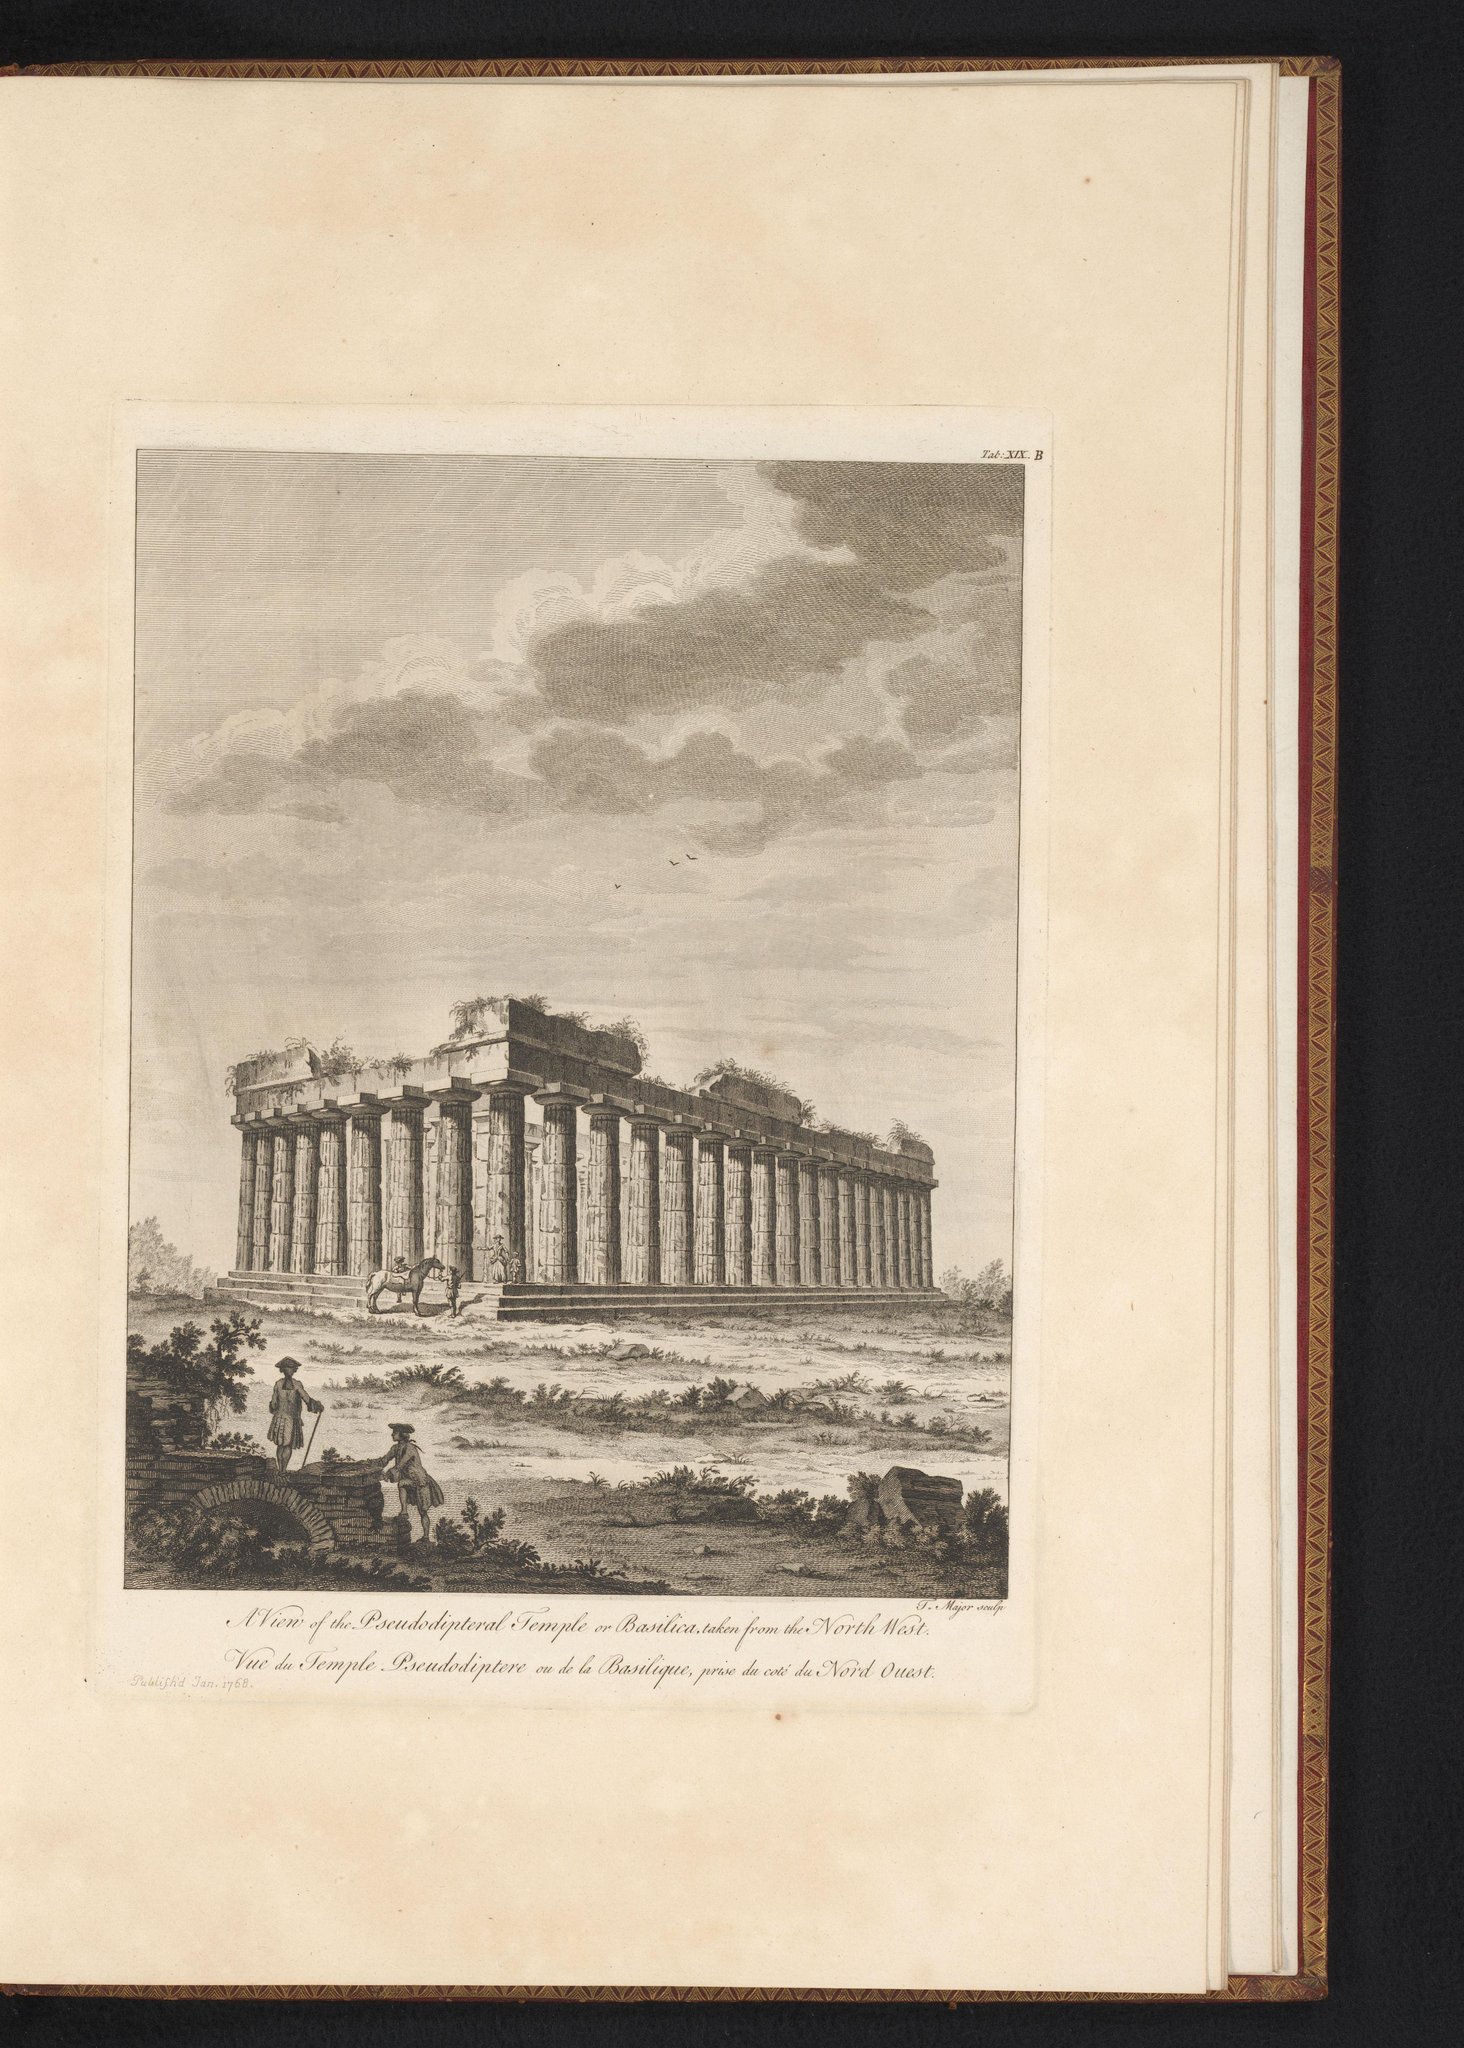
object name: page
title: Gezicht op een tempel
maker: thomas major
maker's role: print maker, publisher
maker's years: 1714-1799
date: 1768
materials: paper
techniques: engraving, etching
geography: london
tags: landscape with ruins (+ city(-scape) with figures, staffage), temple, shrine ~ greek religion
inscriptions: date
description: Deze prent is onderdeel van de reeks van 25 genummerde illustraties in deze uitgave.